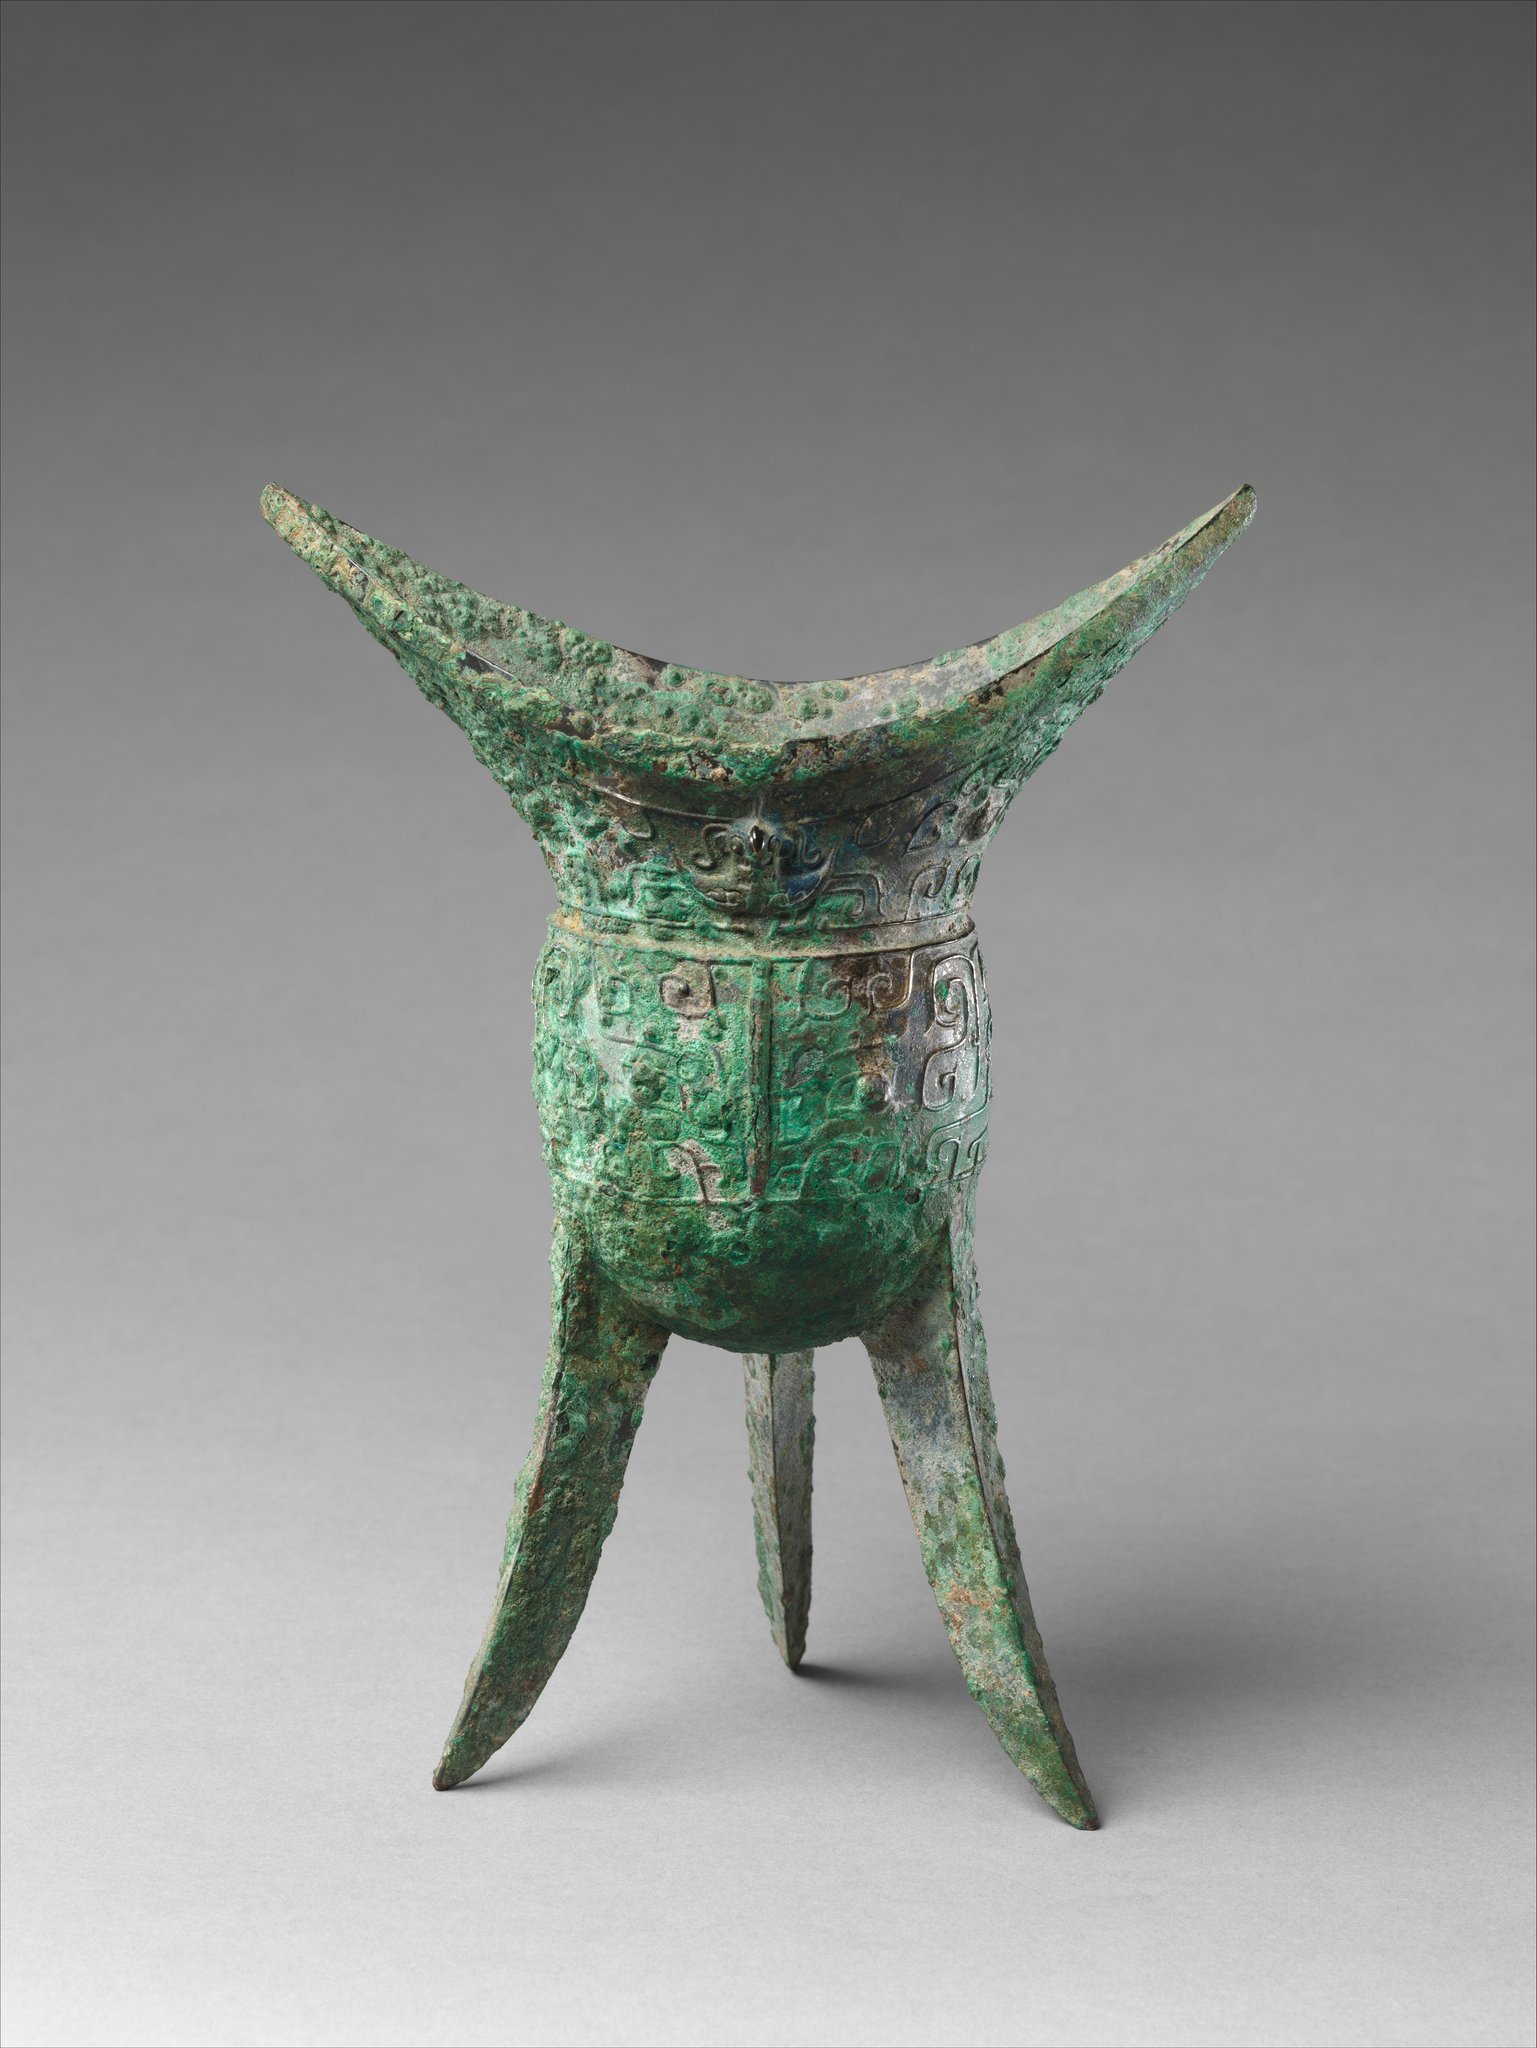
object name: wine vessel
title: Ritual Wine Vessel (Jiao)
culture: chinese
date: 1034-1001 BCE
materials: bronze